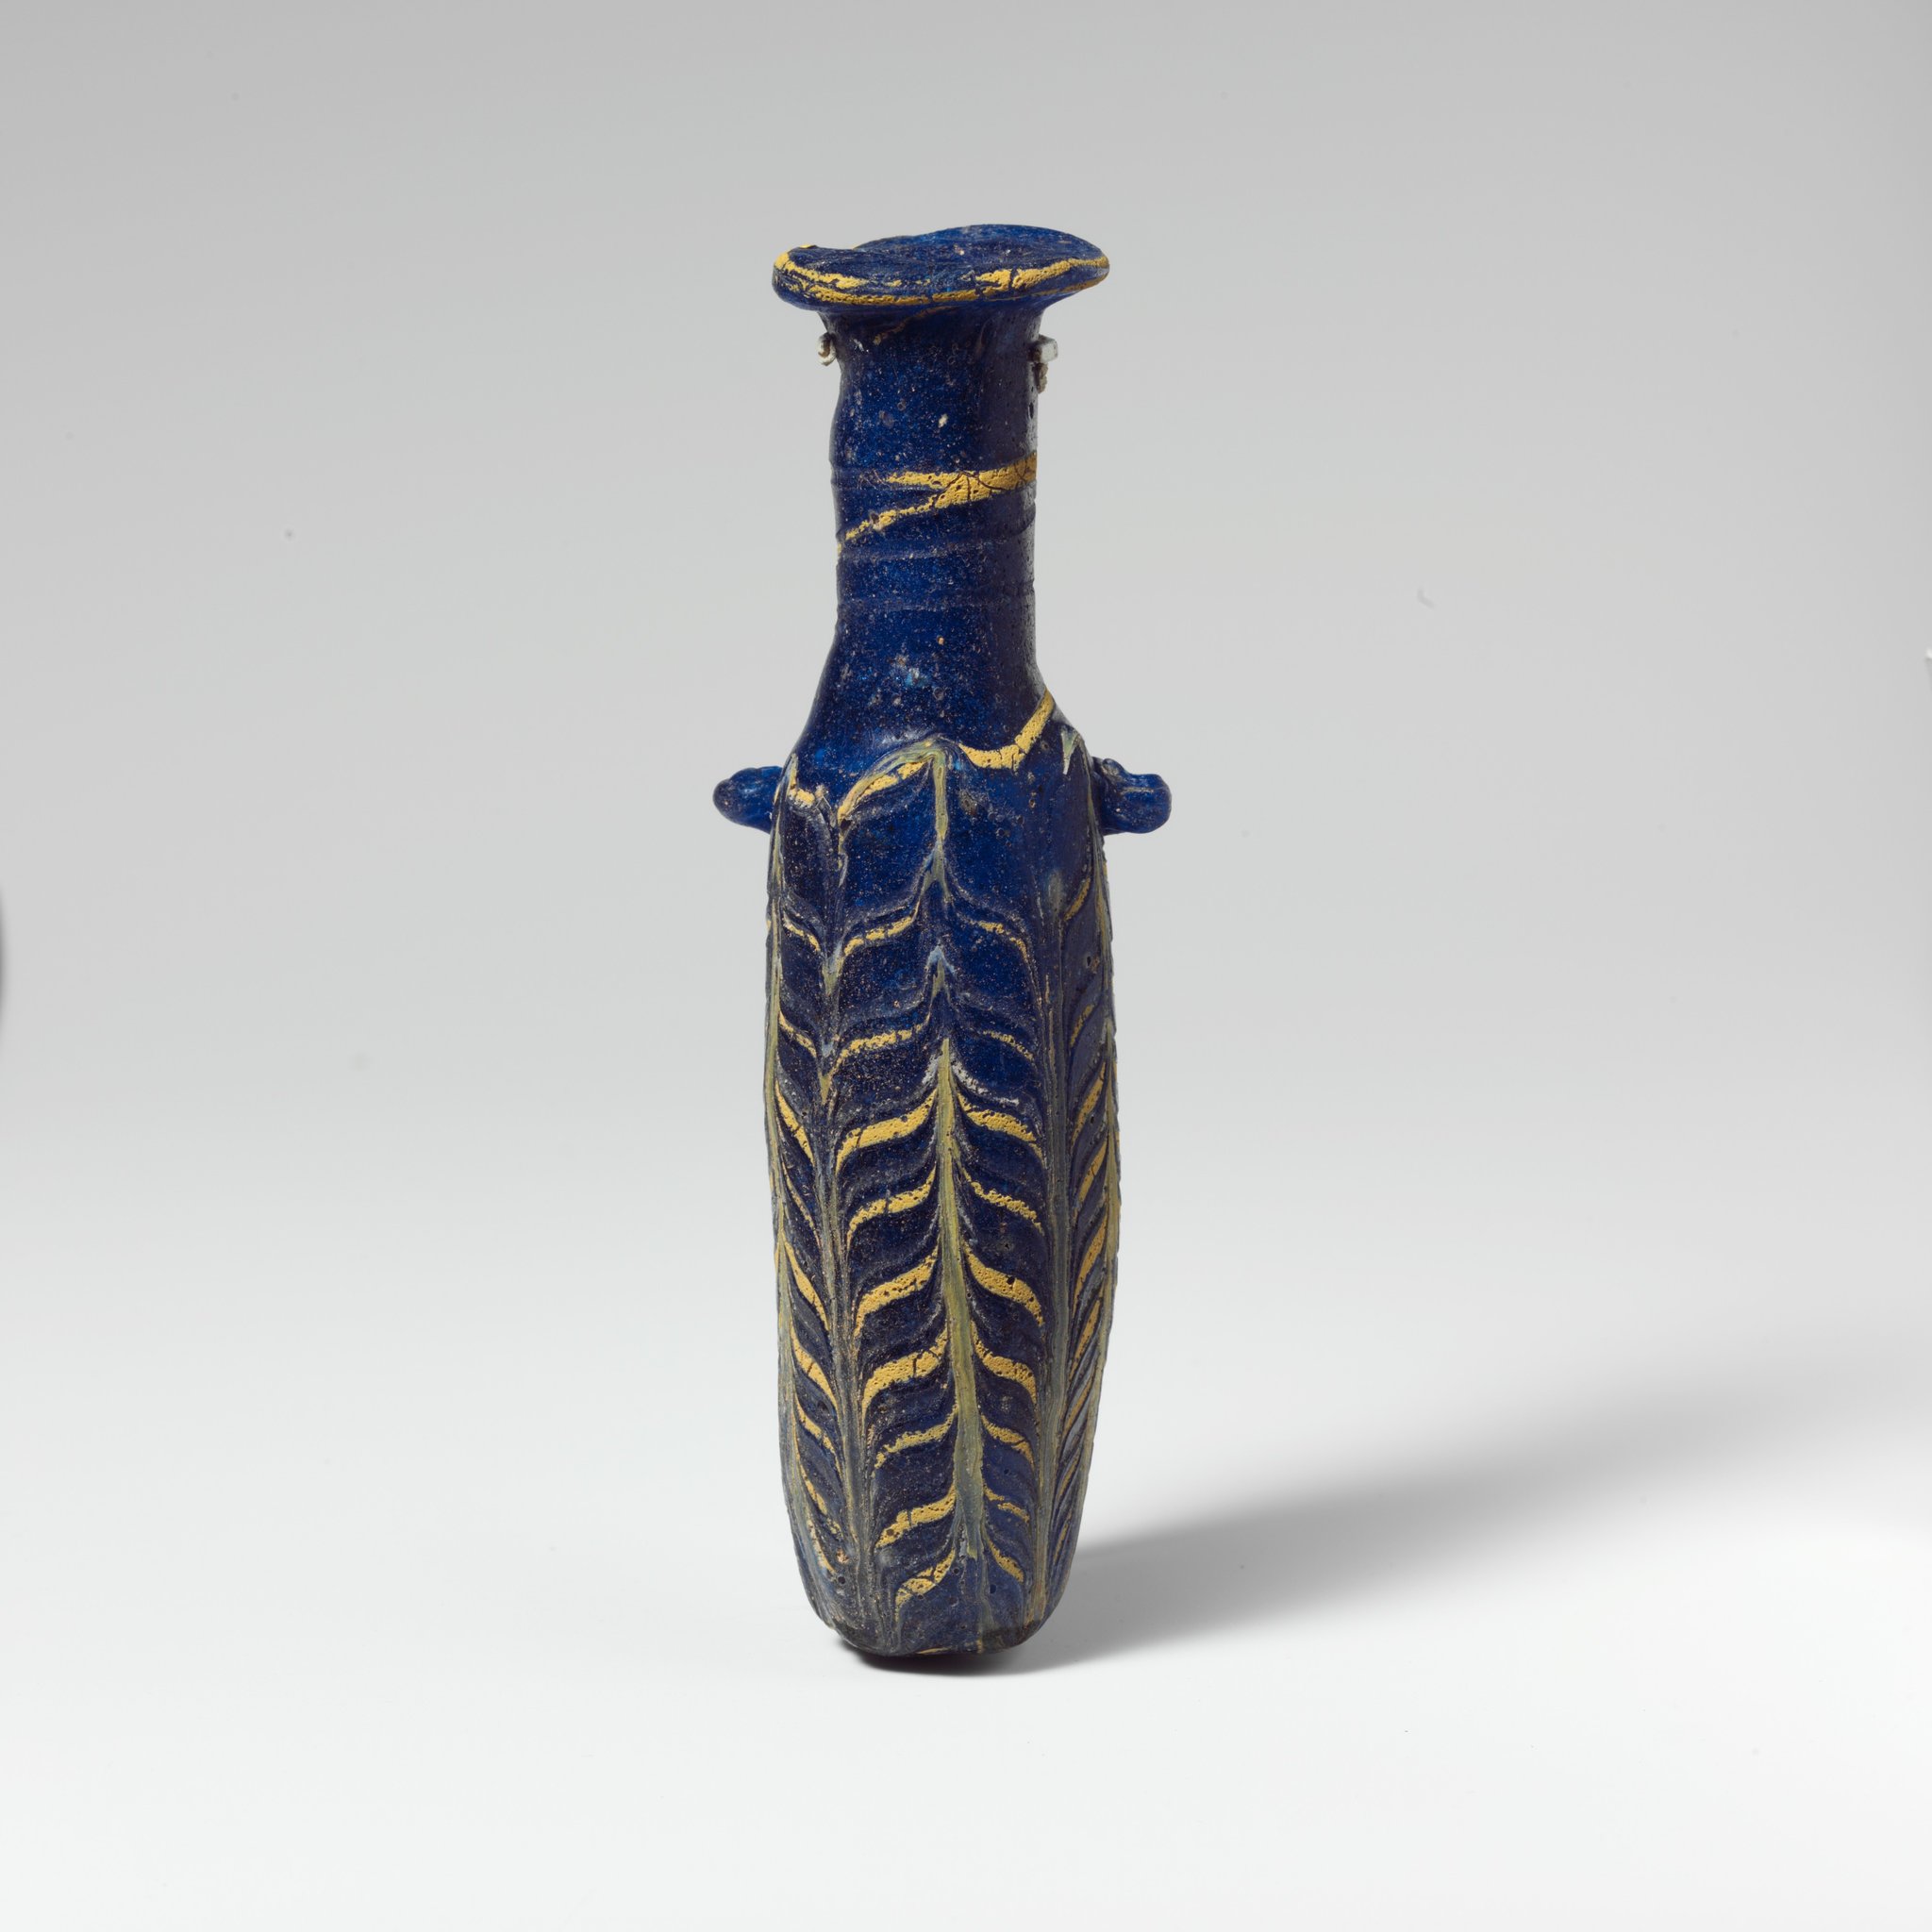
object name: alabastron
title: Glass alabastron (perfume bottle)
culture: greek, eastern mediterranean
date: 300-101 BCE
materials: glass